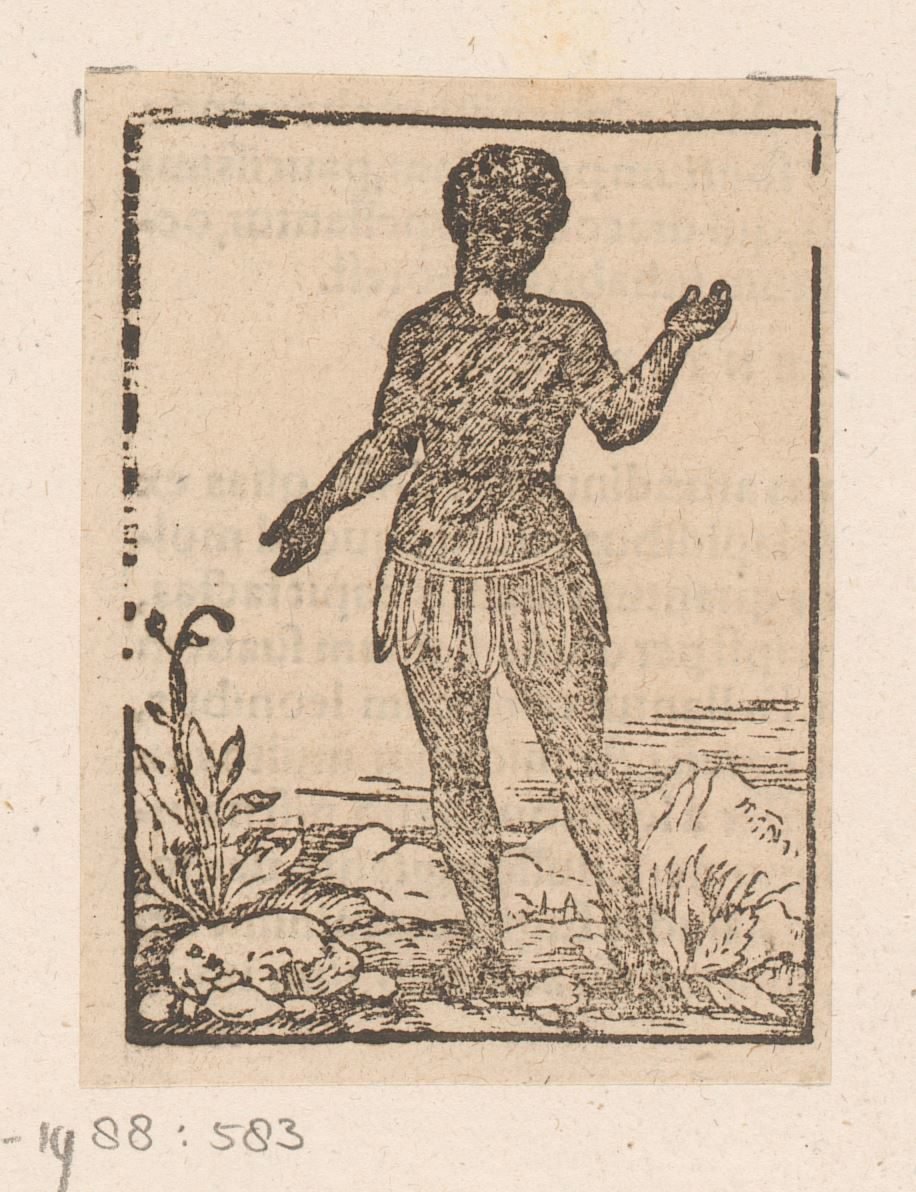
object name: book illustration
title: Staande zwarte man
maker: Anonymous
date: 1500-1599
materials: paper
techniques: woodcut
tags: africans, adult man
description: Prent afkomstig uit een onbekende publicatie.